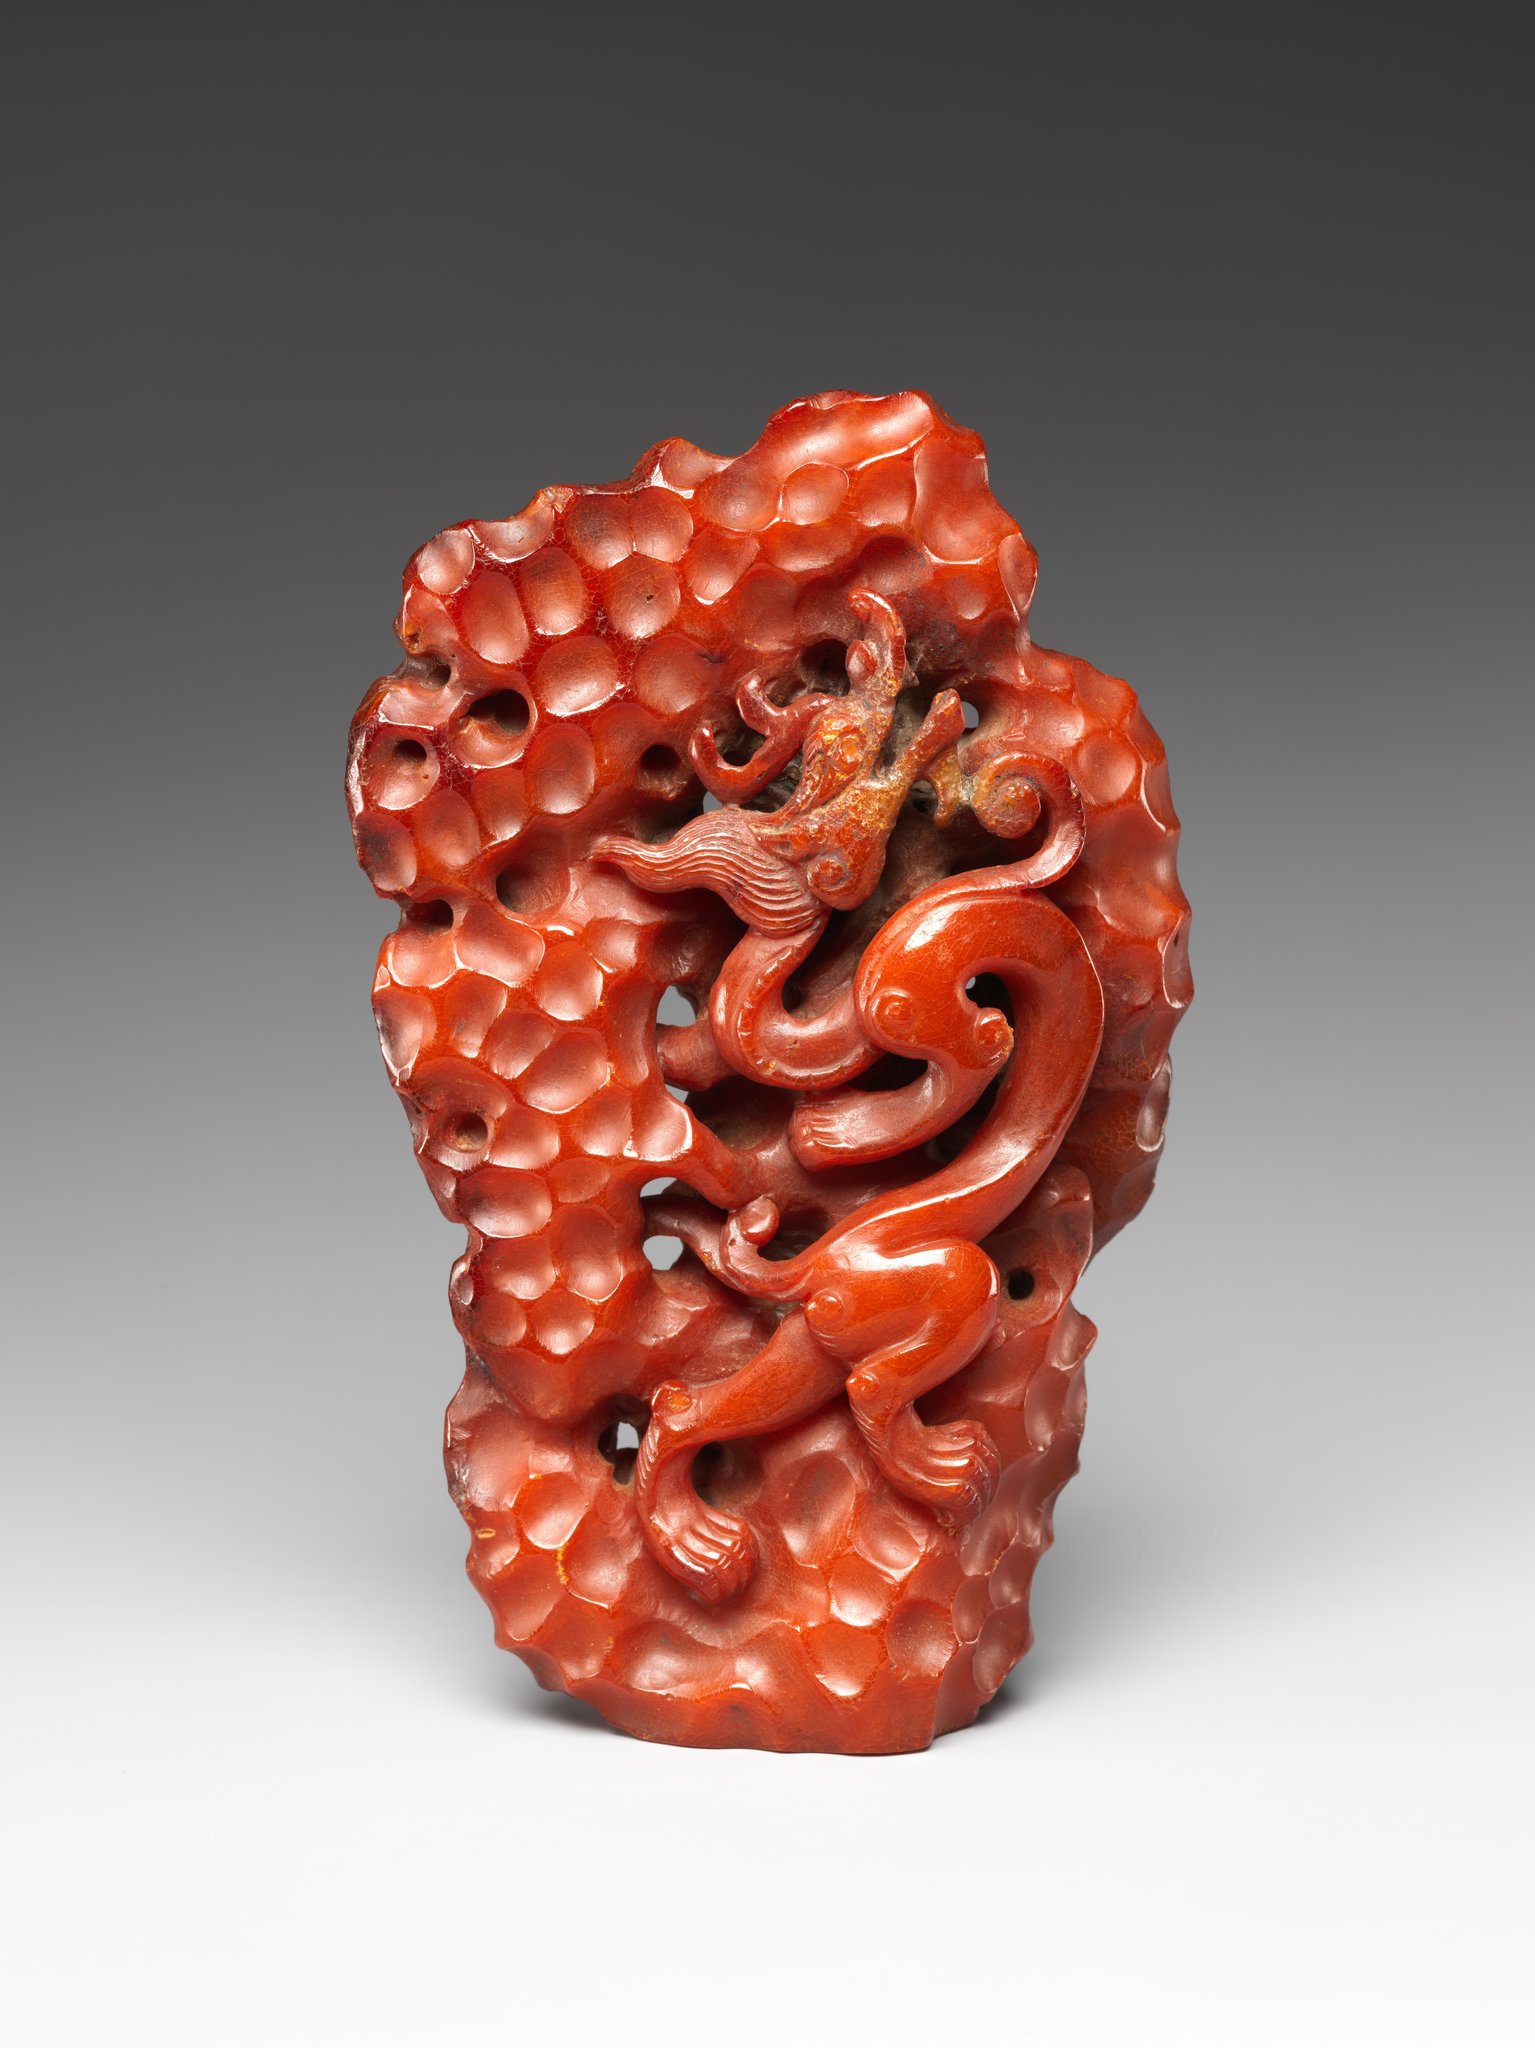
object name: ornament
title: Dragon climbing a rock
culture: chinese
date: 1301-1400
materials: amber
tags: dragons